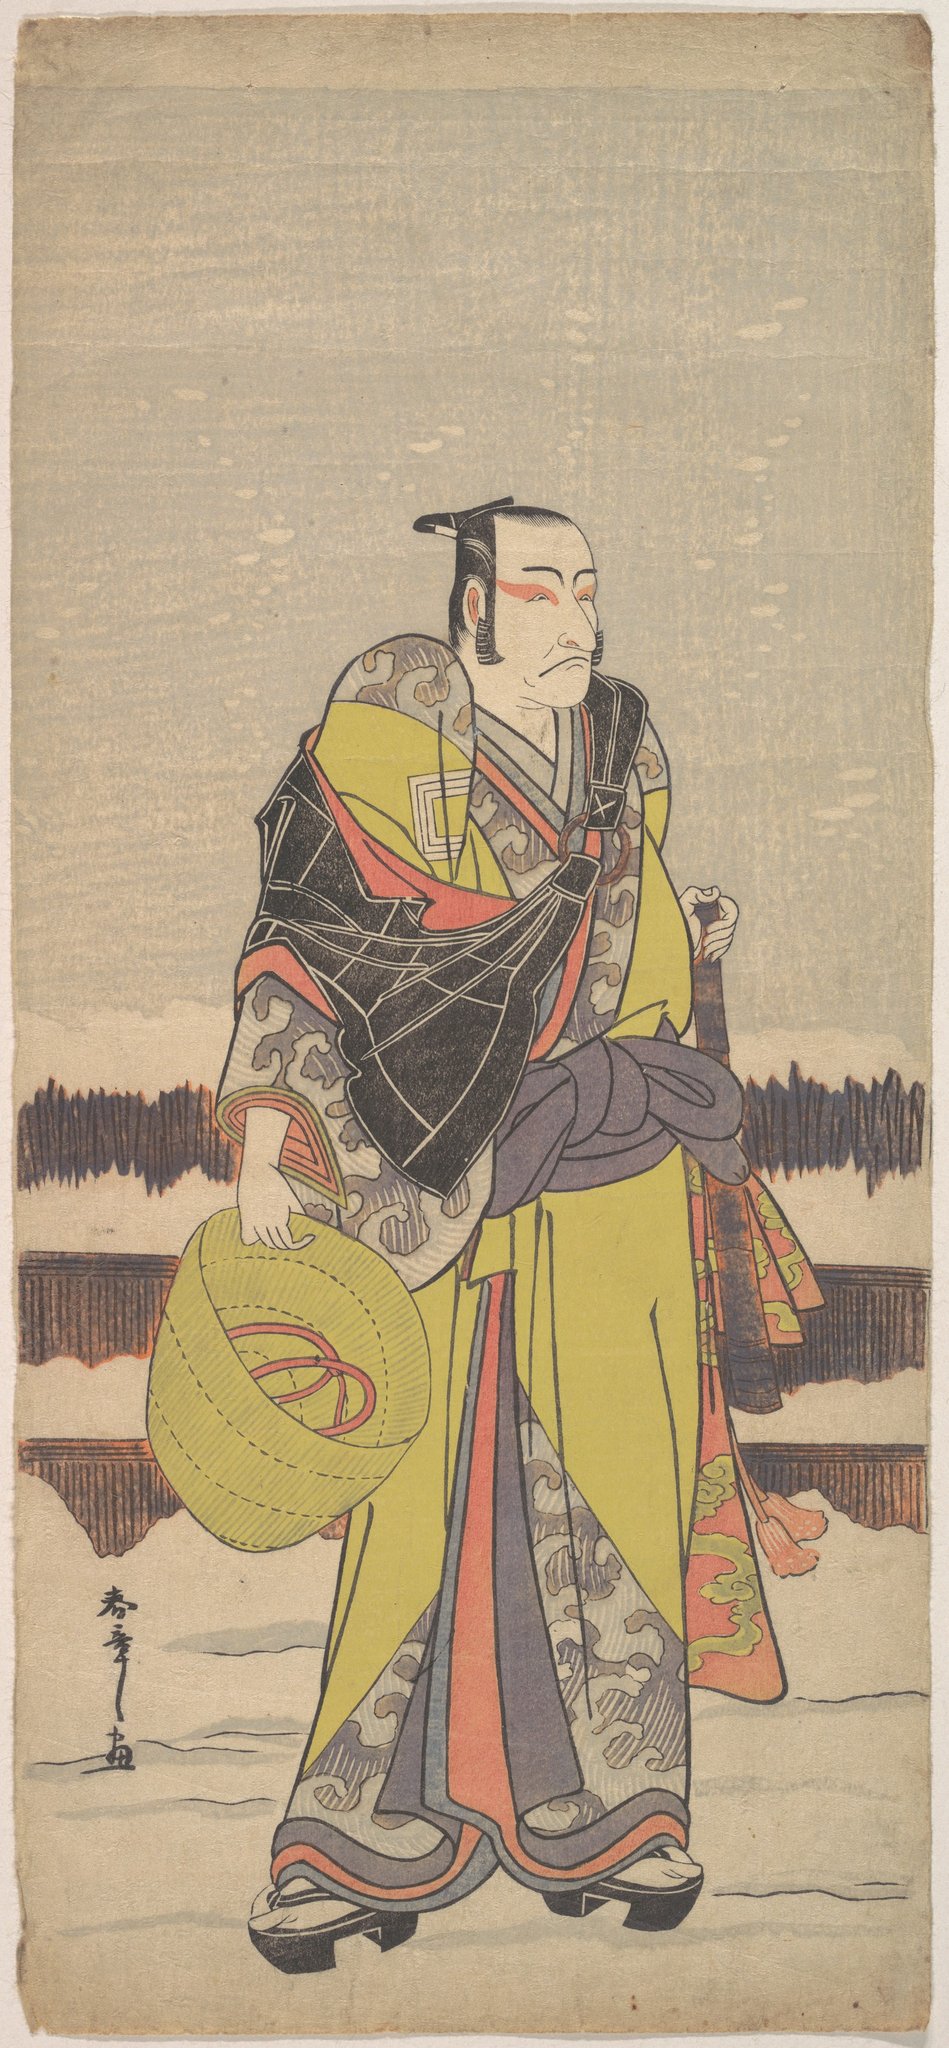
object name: woodblock print nishiki e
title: Danjurō V as Kakogawa Honzō with a Komuso Hat and a Flageolet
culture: japanese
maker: katsukawa shunshō 勝川春章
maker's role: artist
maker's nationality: japanese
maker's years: 1726-1792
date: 1726-1792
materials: ink, paper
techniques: nishiki e, woodblock print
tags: hats,men,actors